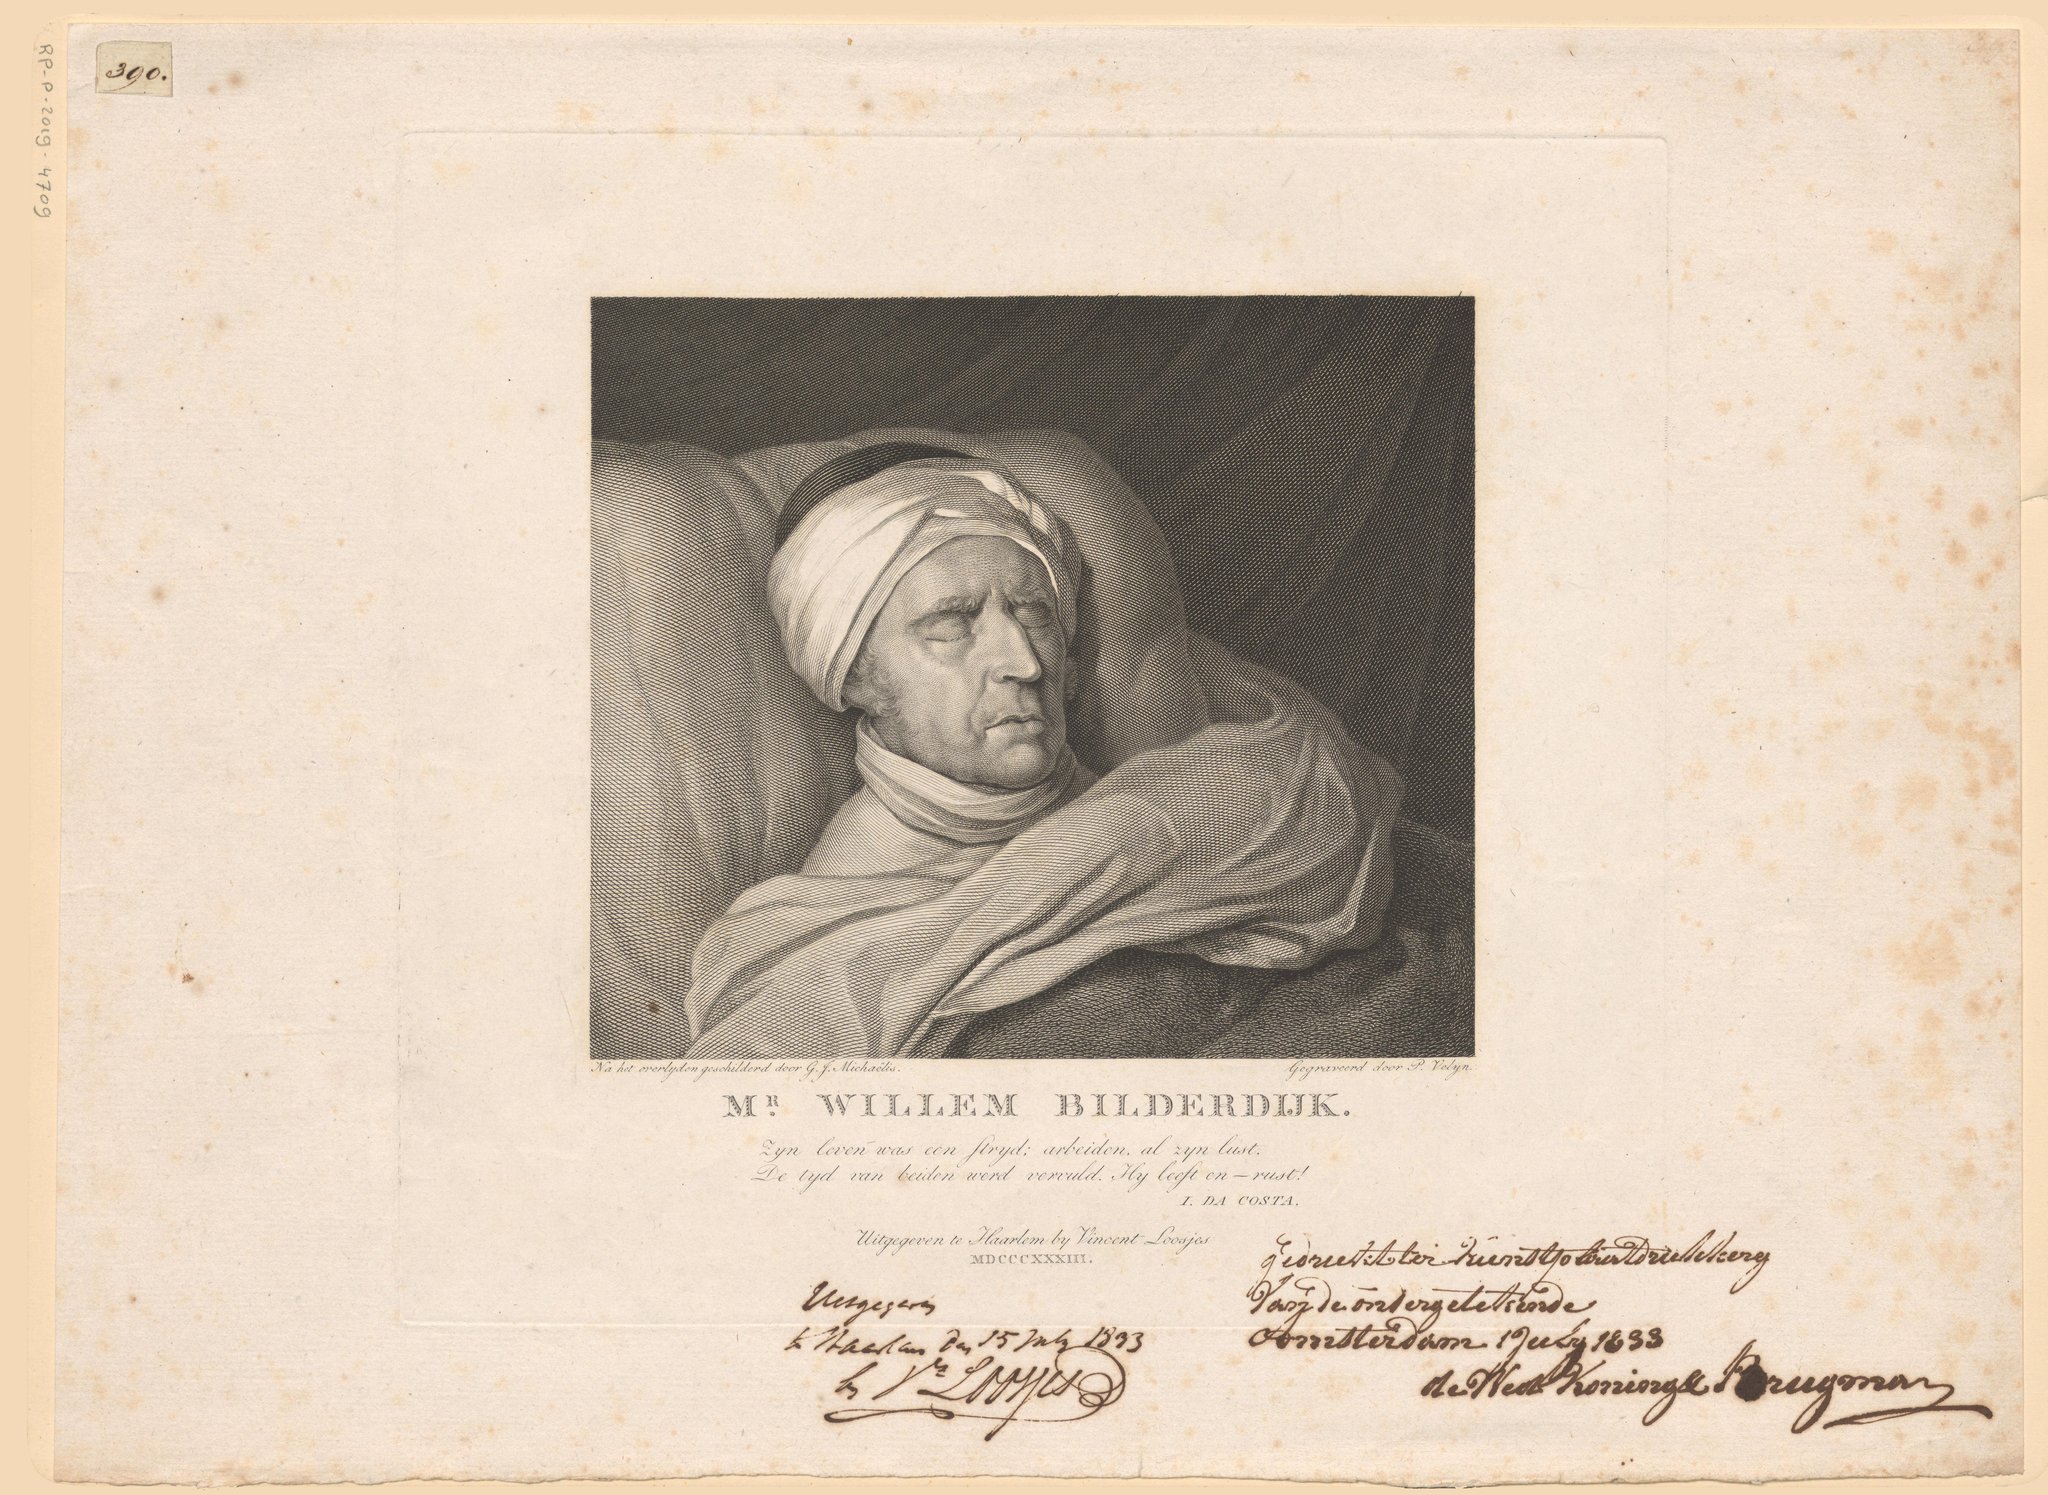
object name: print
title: Willem Bilderdijk op zijn doodsbed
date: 1833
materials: paper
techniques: engraving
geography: haarlem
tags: amsterdam, haarlem, print maker, draughtsman, willem bilderdijk, deathbed, historical persons, artist on his deathbed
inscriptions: inscription: ‘Uitgegeven te Haarlem den 15 july 1833 bij Vt. Loosjes [...]’